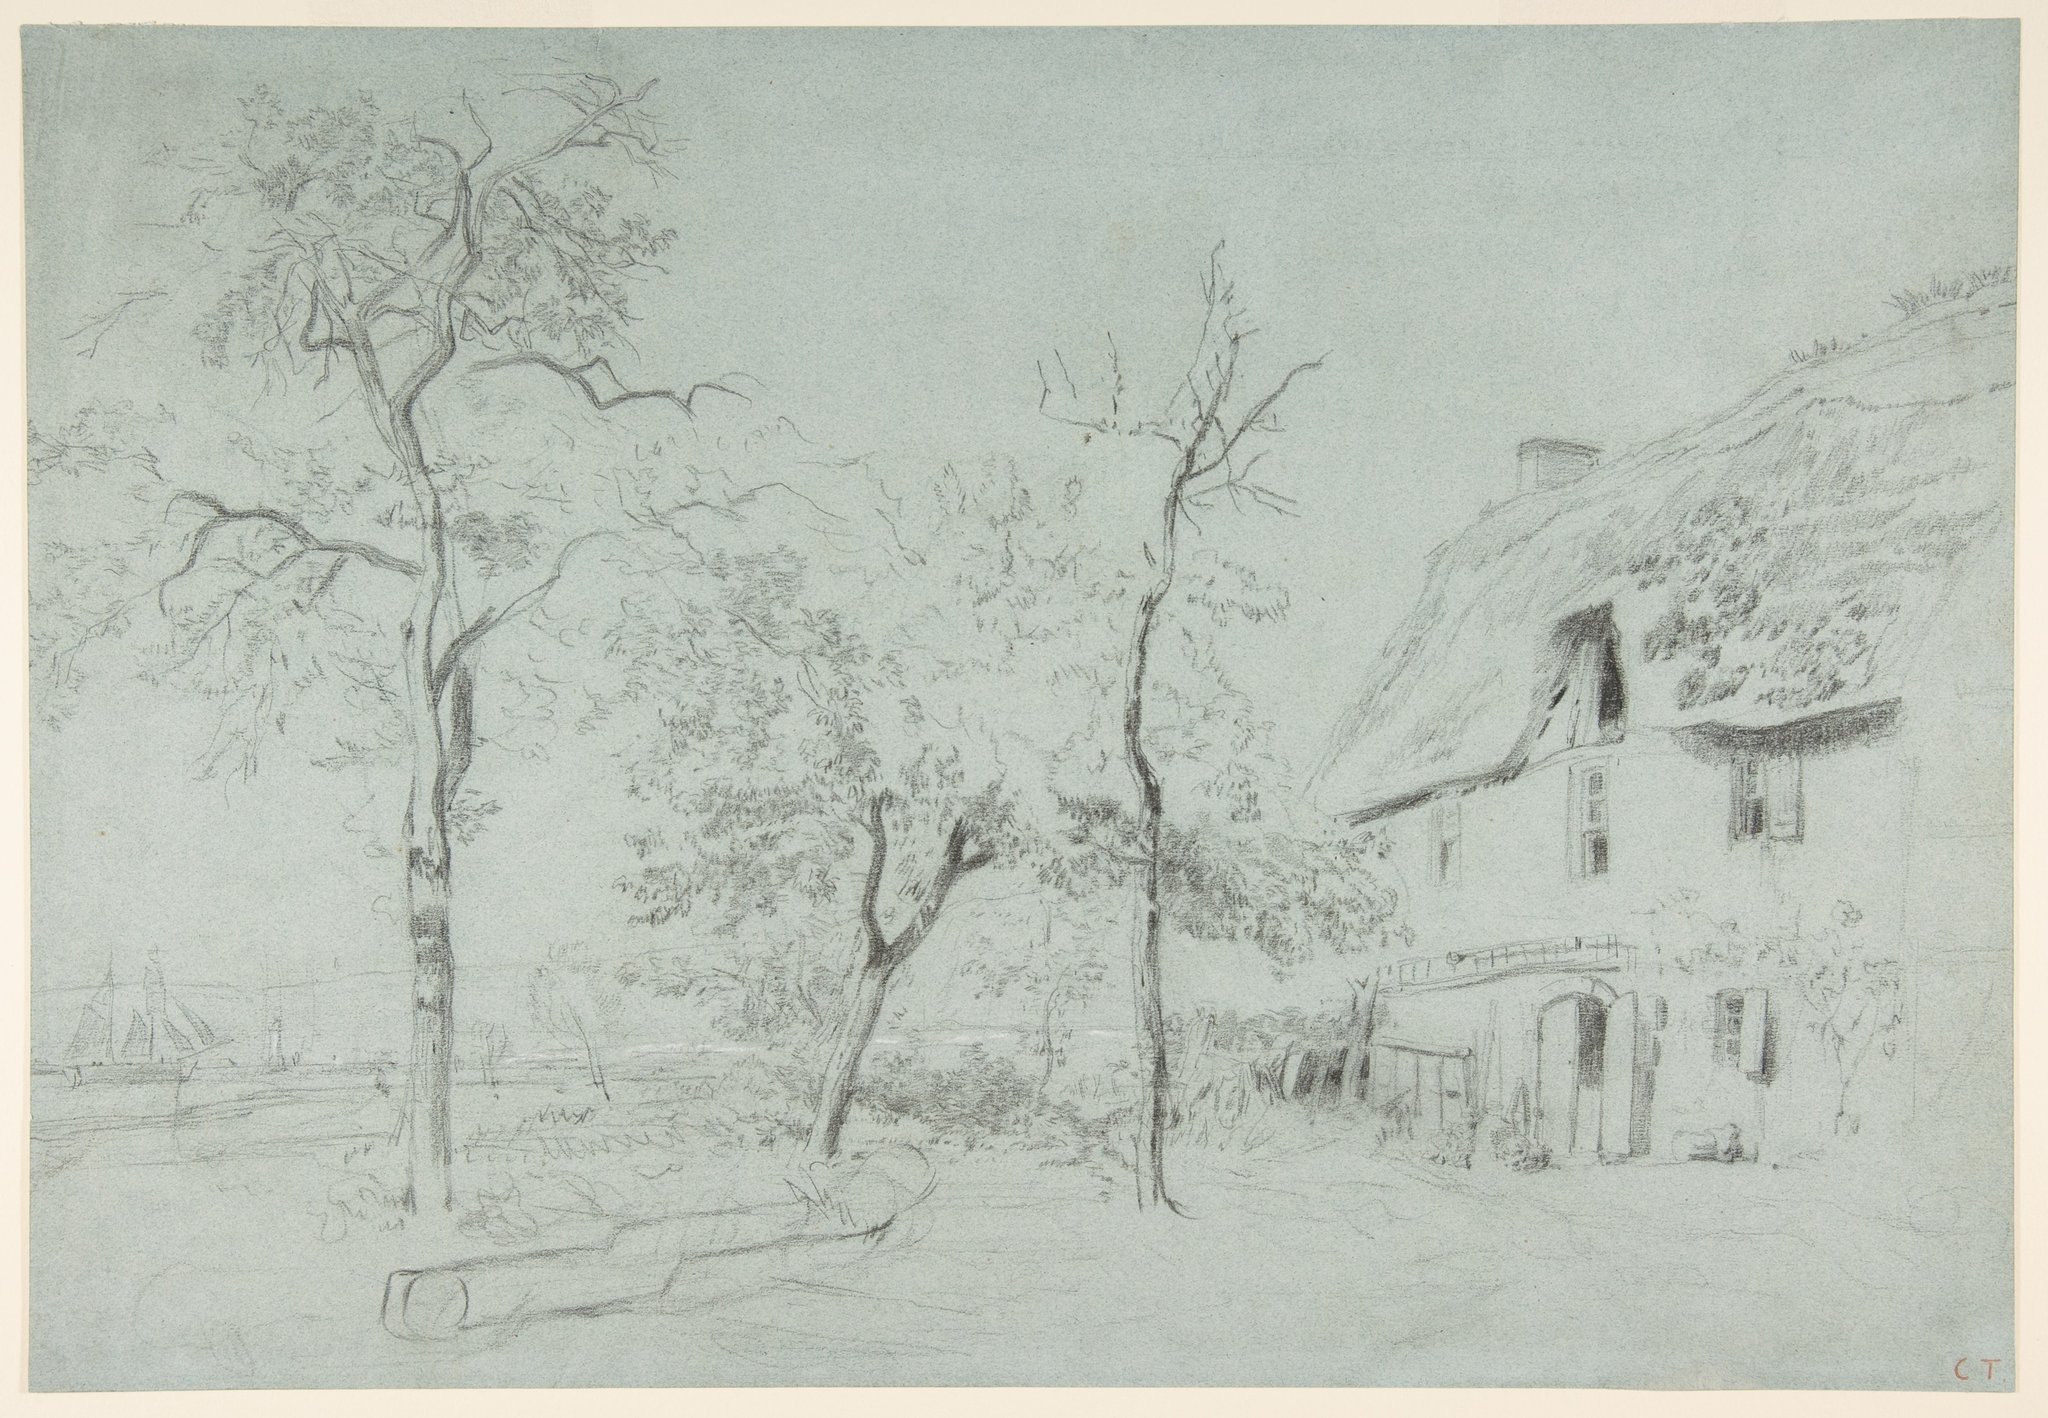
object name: drawing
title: A Farmhouse with a Thatched Roof and Trees Beside a River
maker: constant troyon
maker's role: artist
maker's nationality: french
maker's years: 1810-1865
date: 1825-1865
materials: chalk, paper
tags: houses,trees